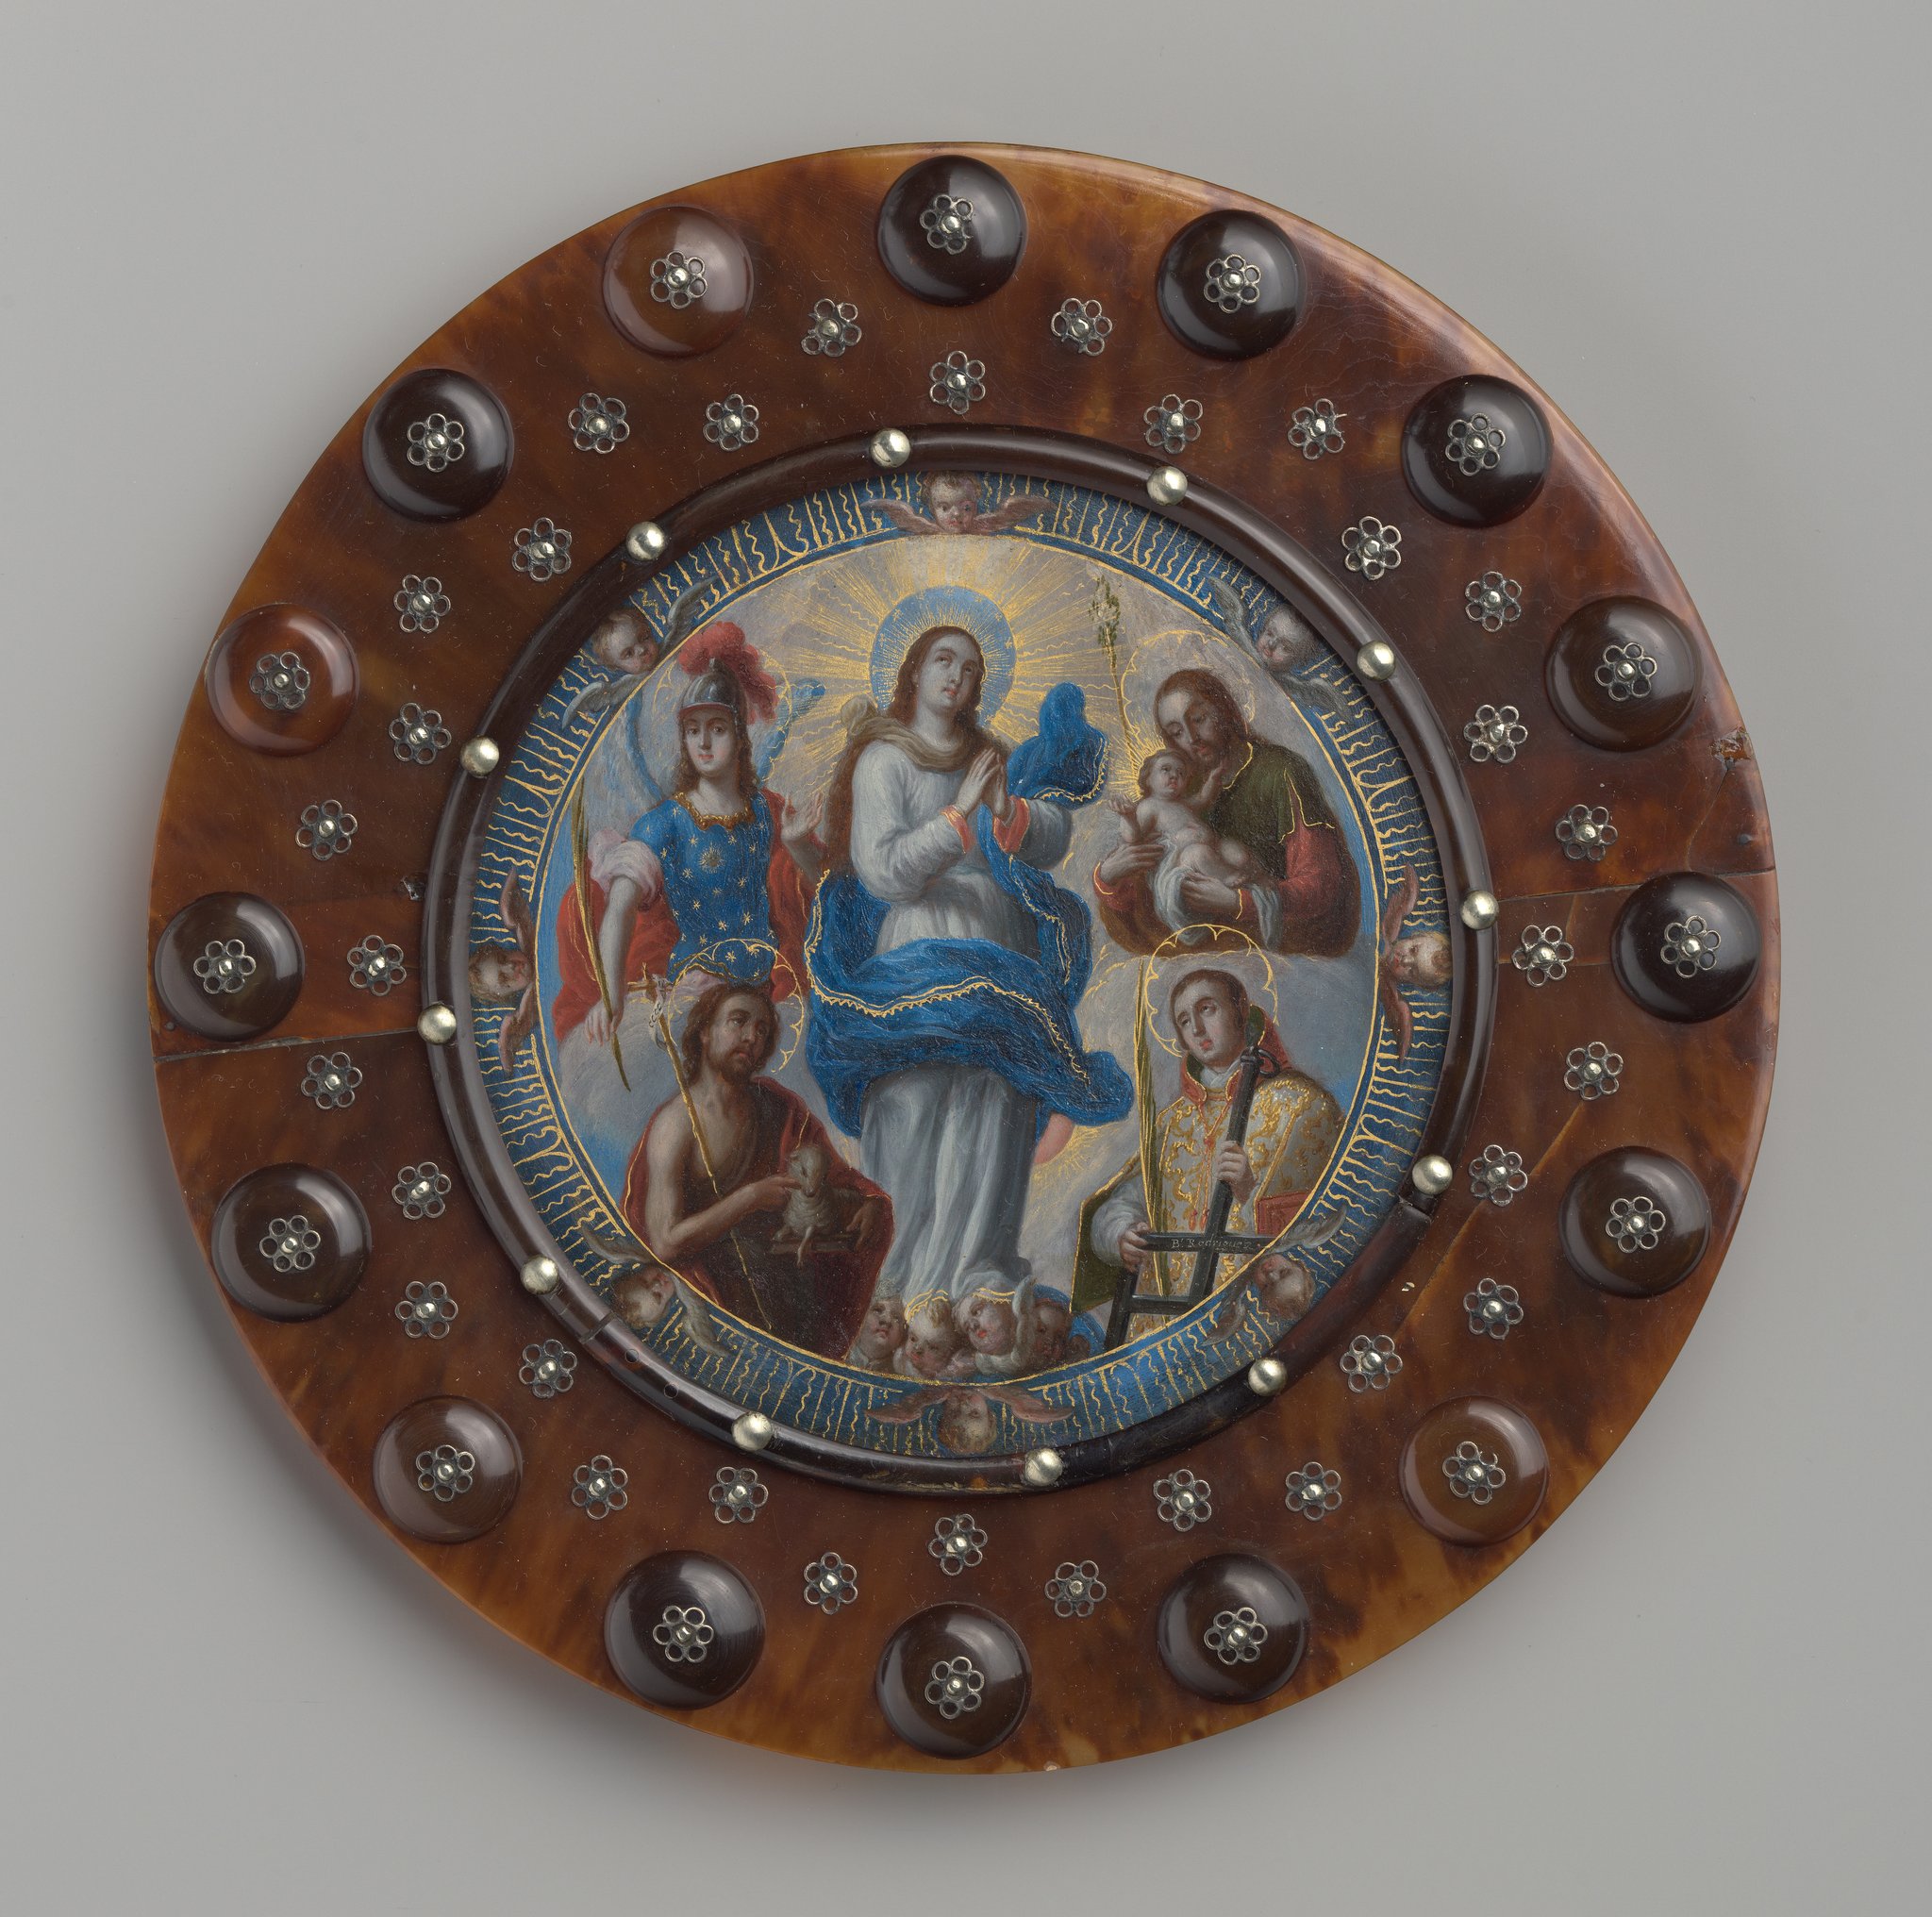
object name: painting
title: Nun’s Badge with the Virgin of the Immaculate Conception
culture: mexican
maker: nicolás rodríguez juárez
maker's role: artist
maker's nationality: mexican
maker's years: 1667-1734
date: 1710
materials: copper, gold, oil, silver, shell